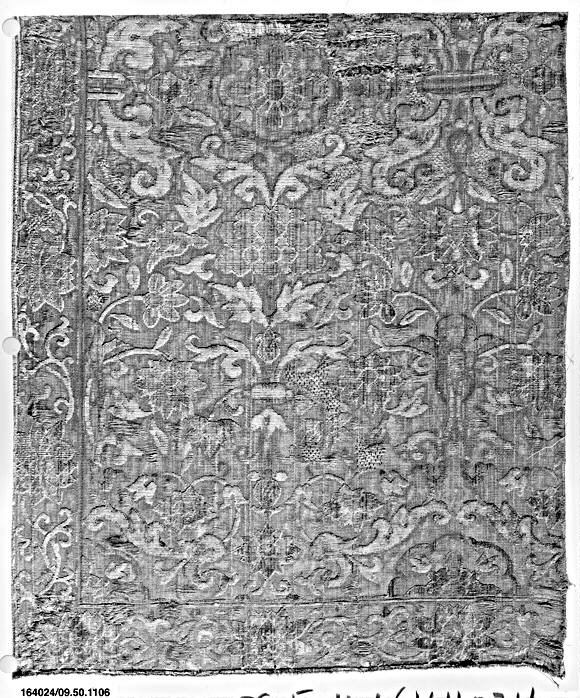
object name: piece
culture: chinese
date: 1701-1800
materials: silk